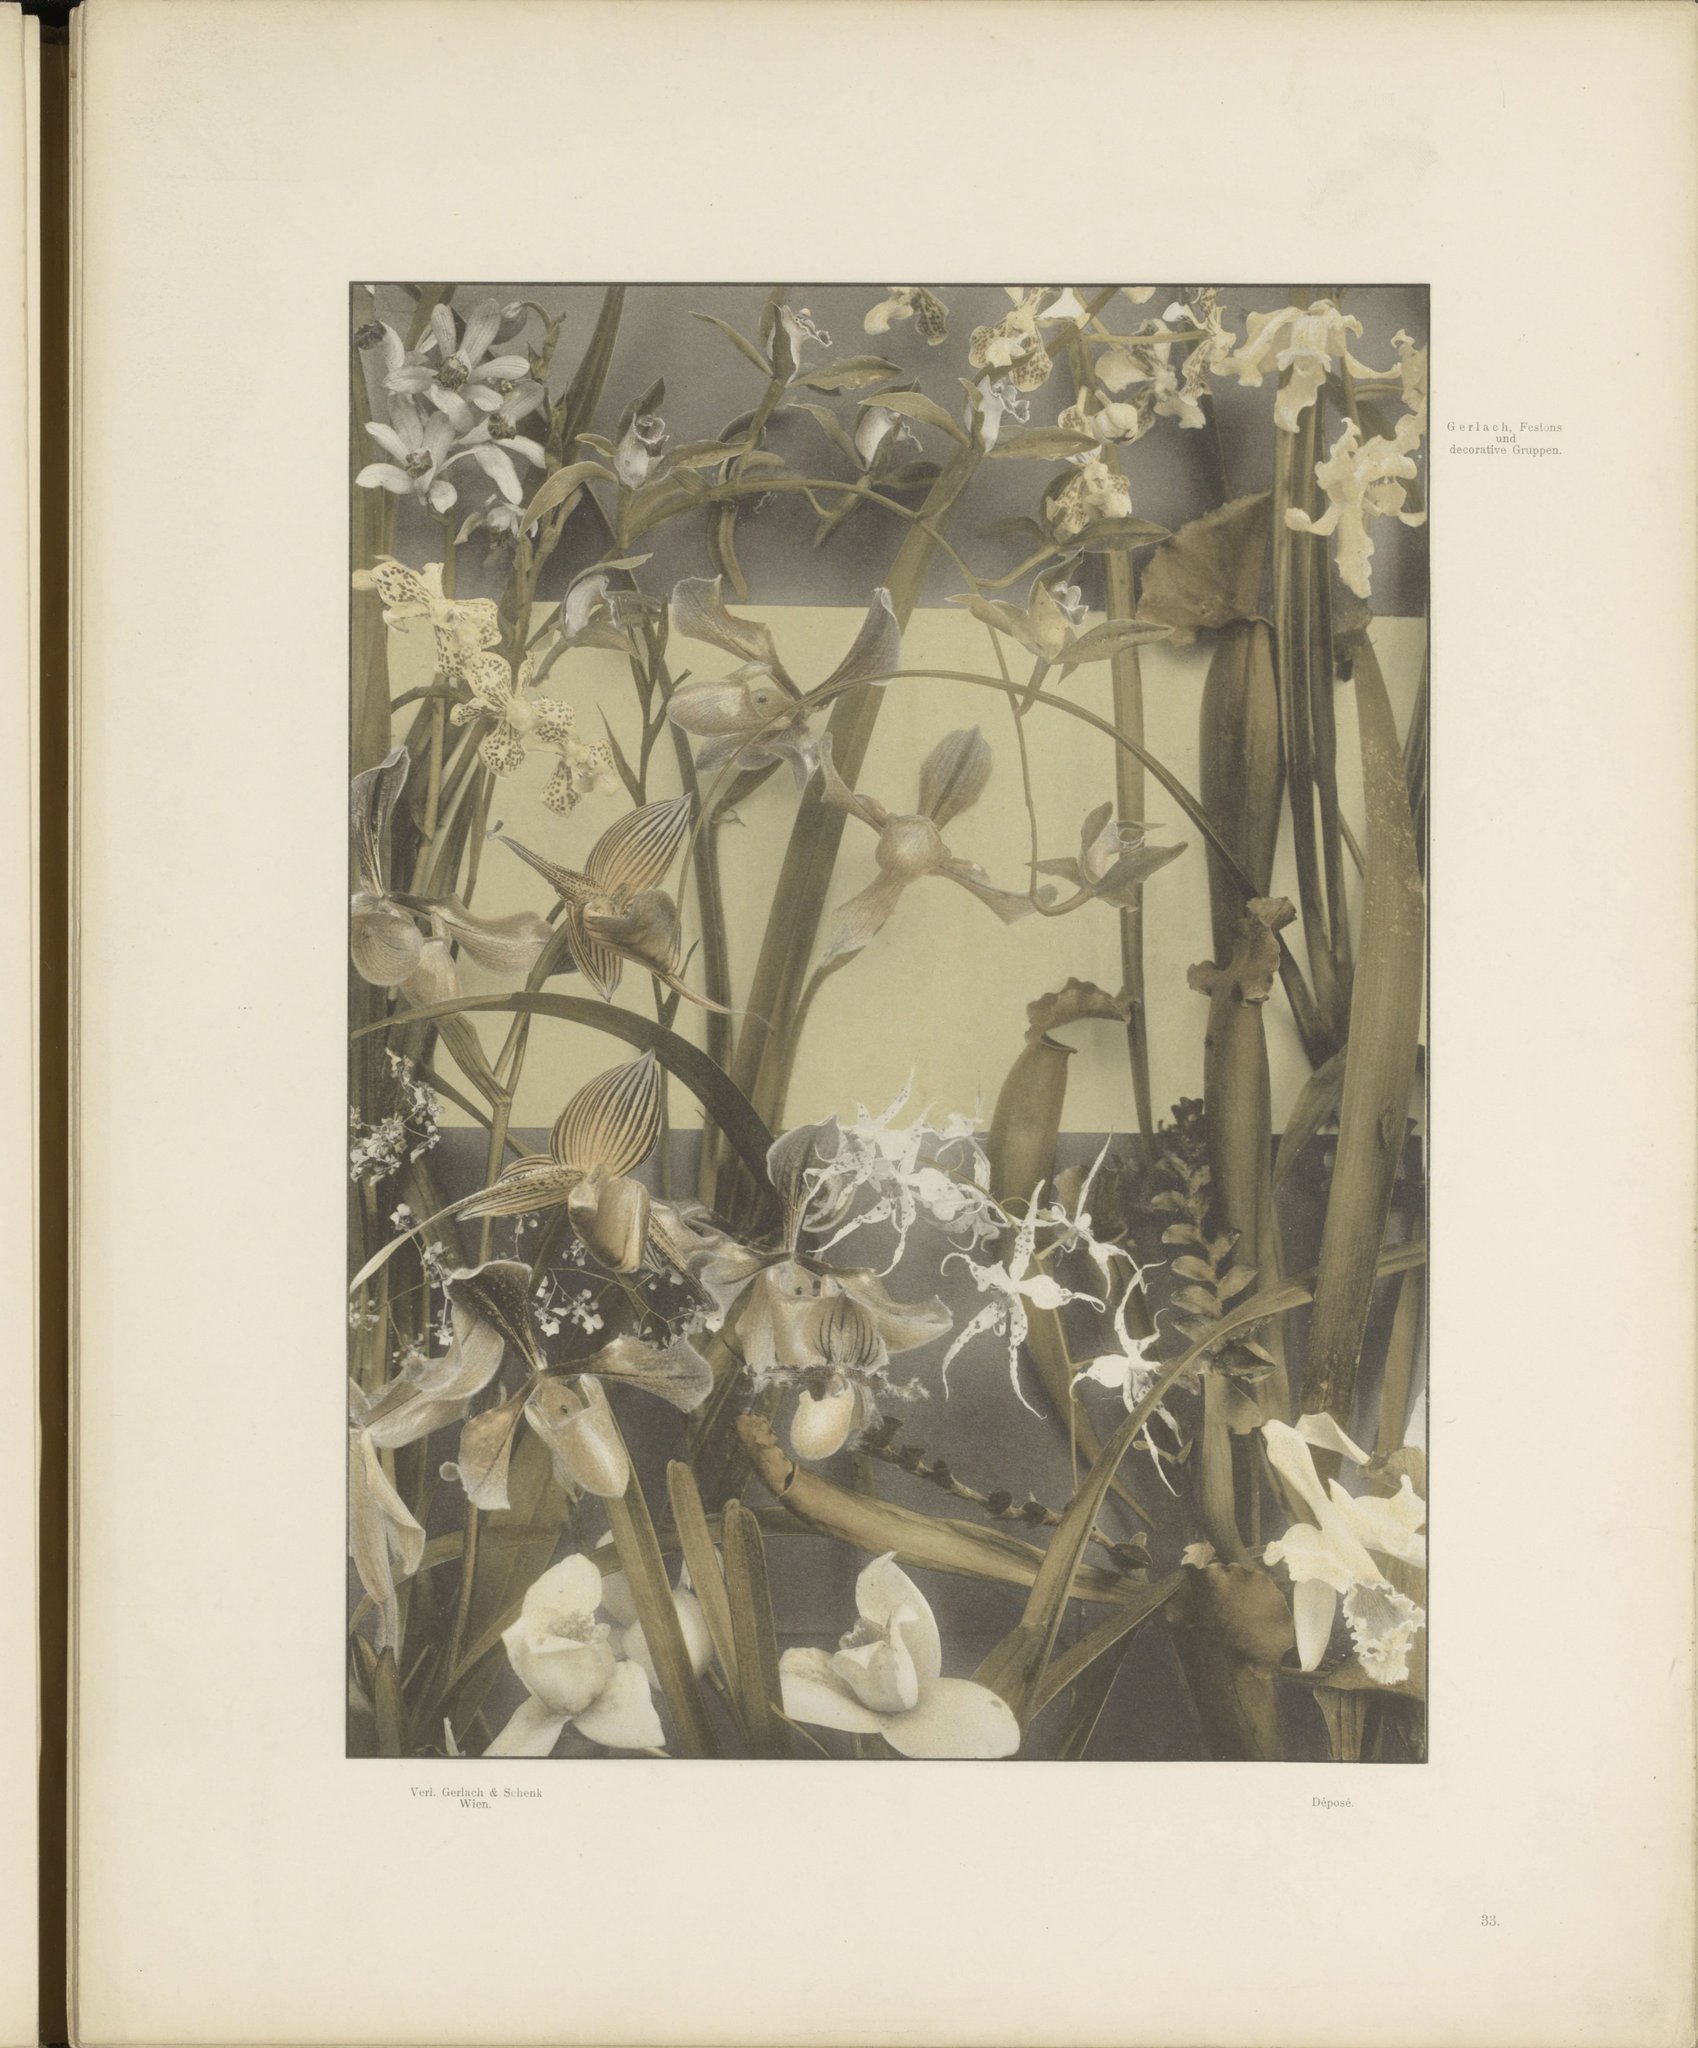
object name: page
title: Decoratieve groep met orchideeën, trompetbekerplanten en venusschoentjes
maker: Anonymous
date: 1887-1897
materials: paper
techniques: photograph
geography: austria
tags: flowers, flowers: orchid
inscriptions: number: ‘33.’